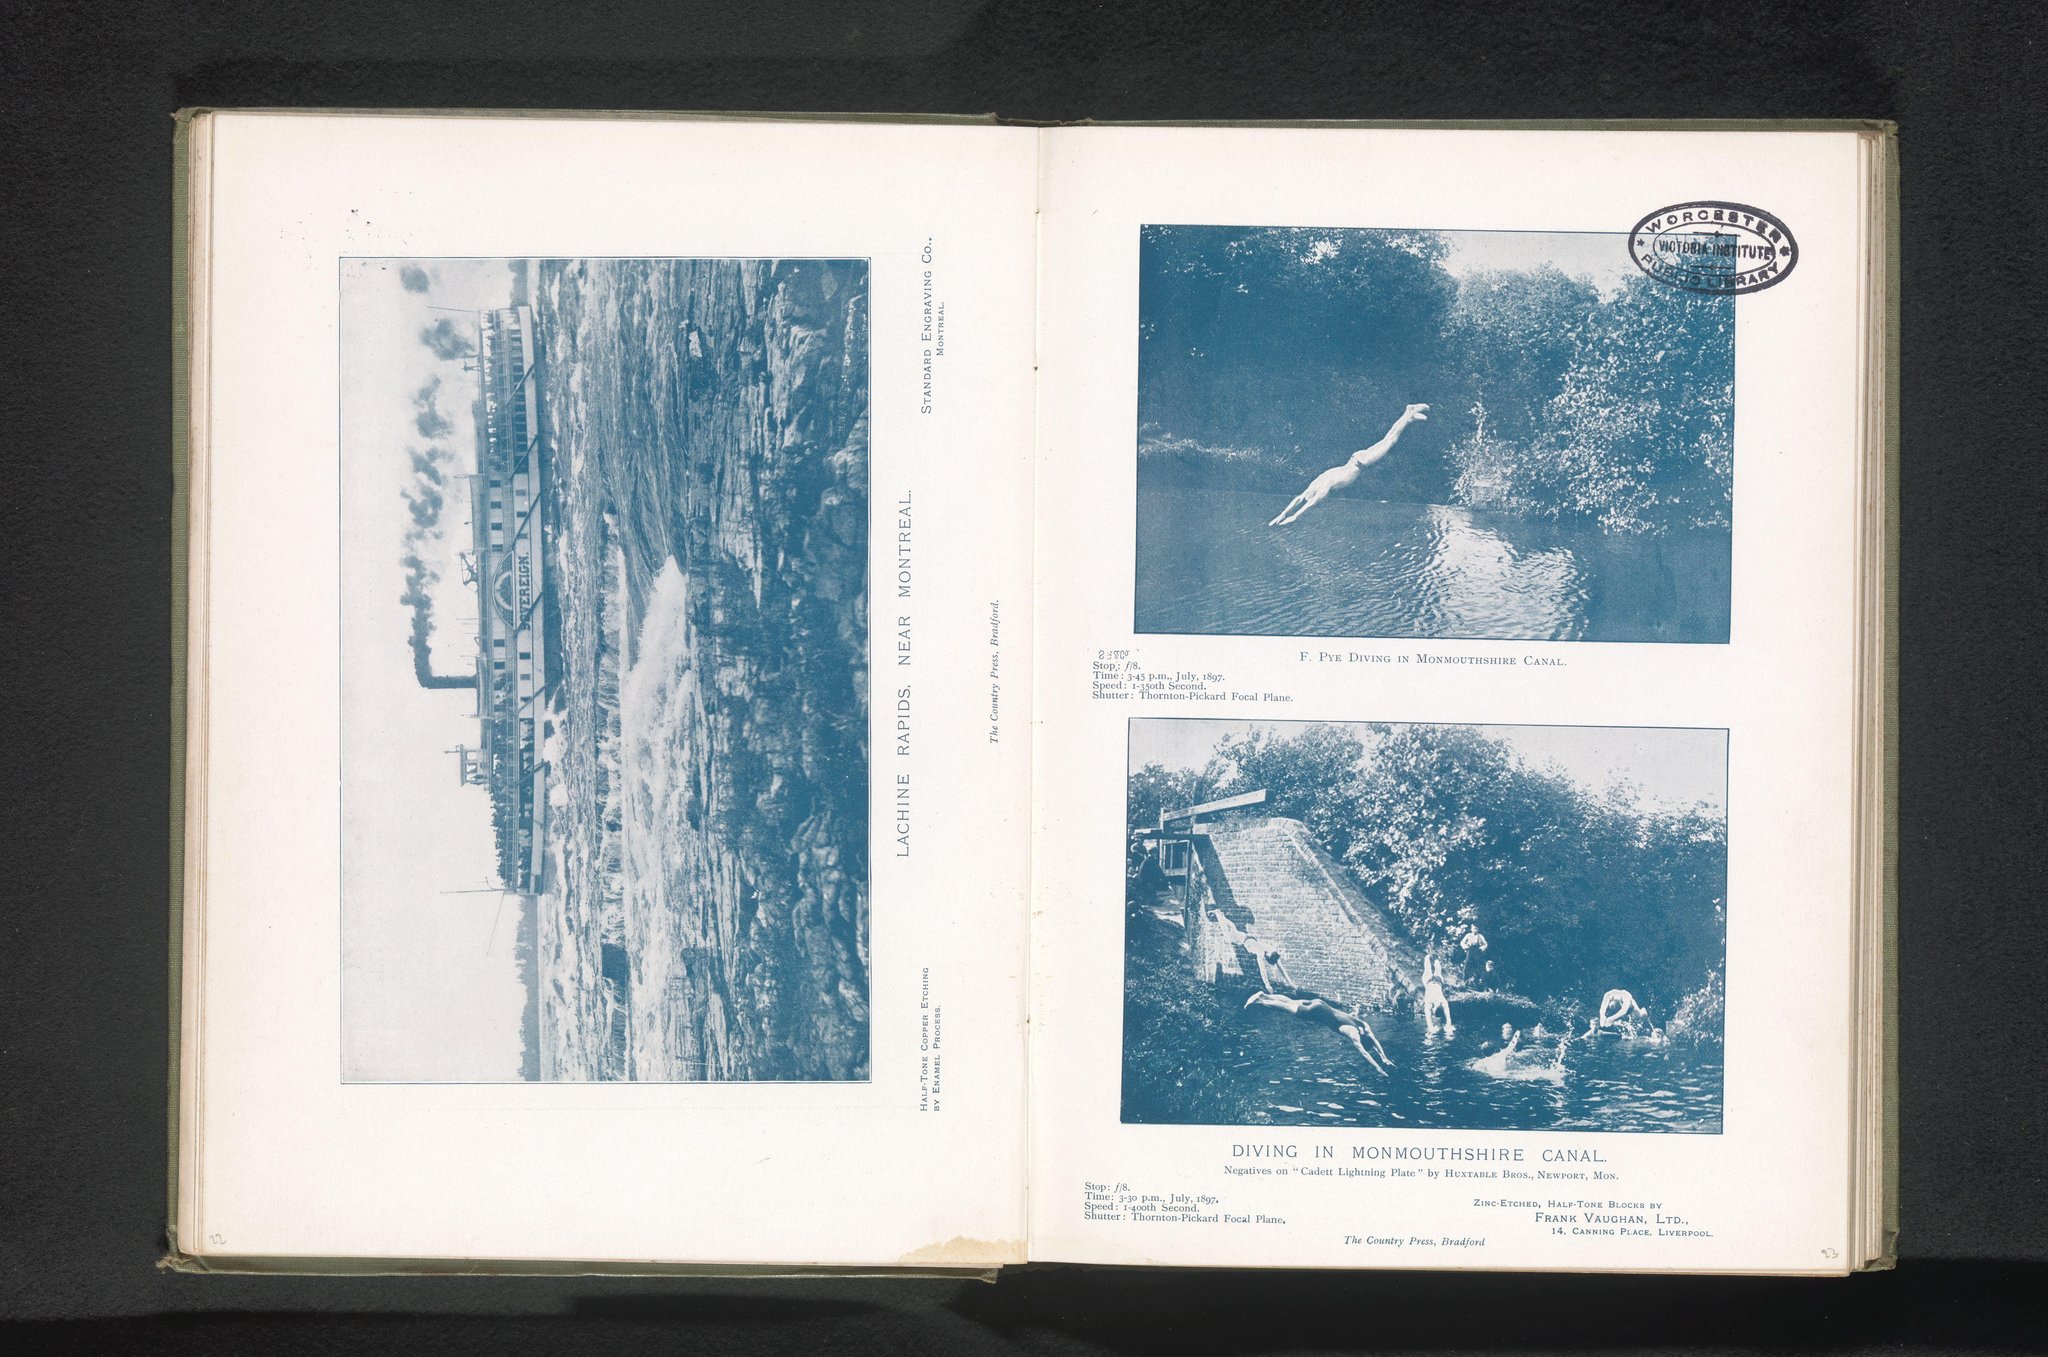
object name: photomechanical print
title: Lachine Rapids, near Montreal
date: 1893-1898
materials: paper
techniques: autotype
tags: rapids, river, steamship, motorship (+ four persons or more ~ traffic and transport)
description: Prent op tweede ongenummerde pagina na pagina 24.